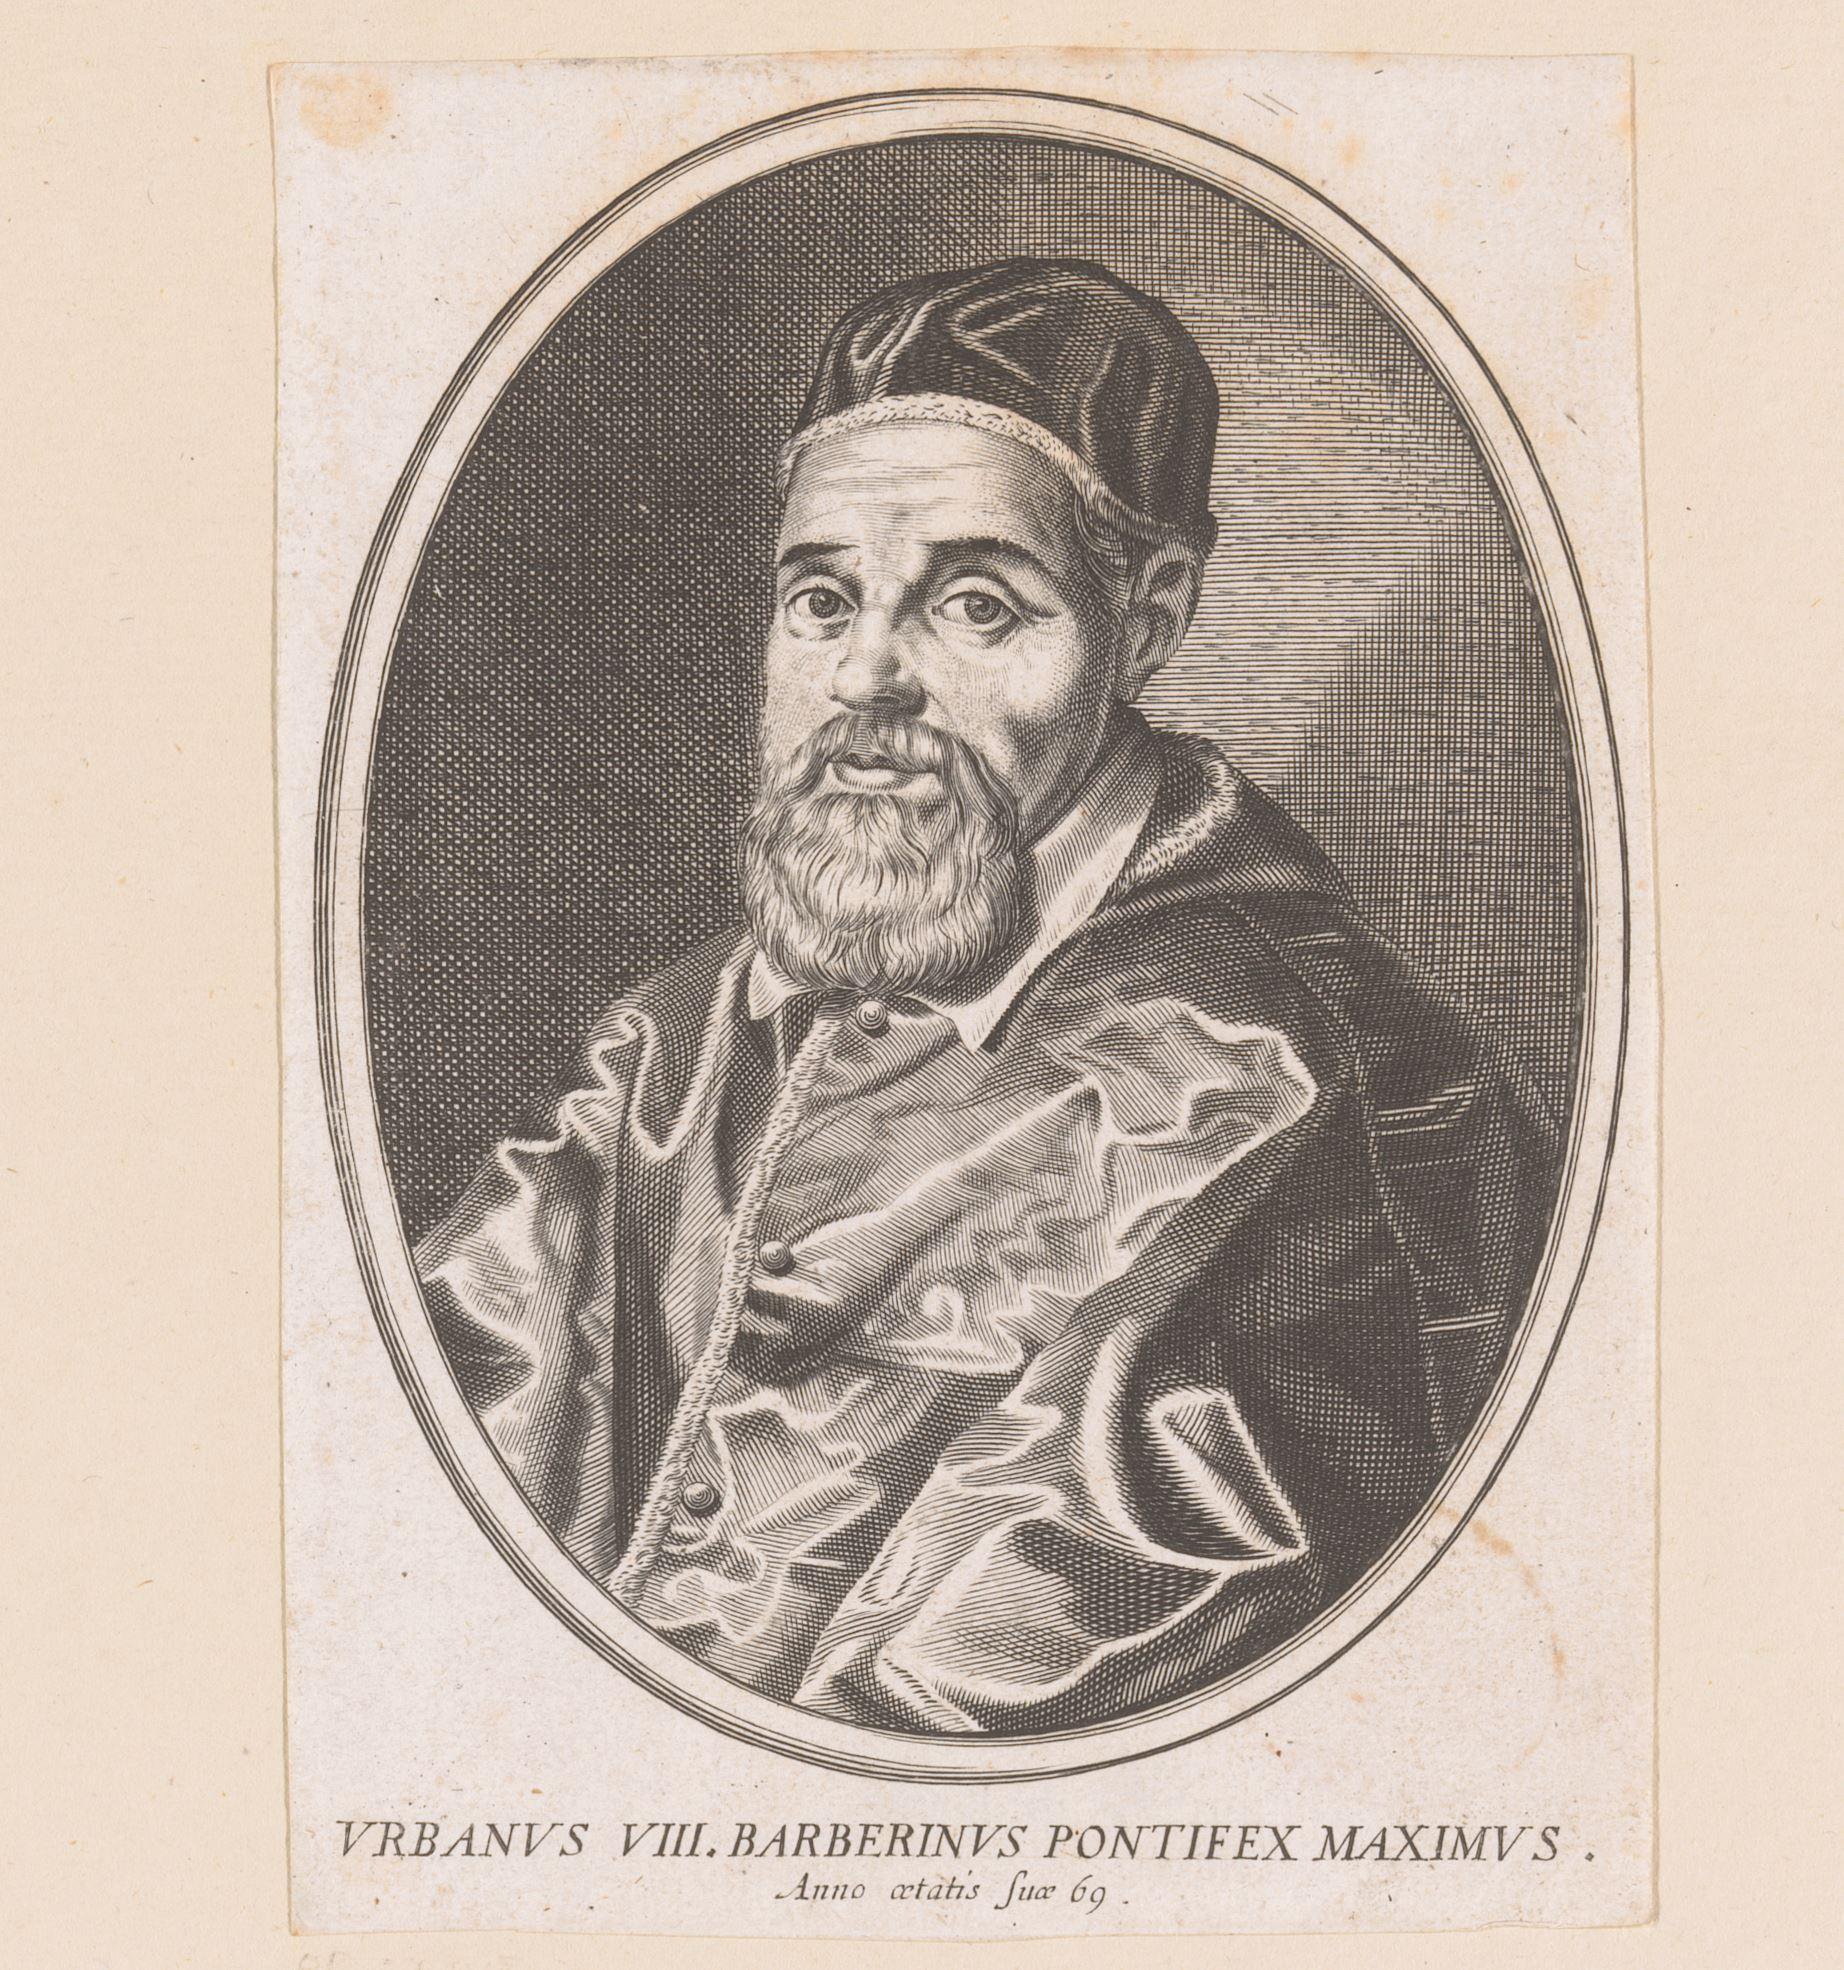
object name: print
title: Portret van paus Urbanus VIII op 69-jarige leeftijd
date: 1610-1668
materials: paper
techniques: engraving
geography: paris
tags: rome, clergyman, urbanus viii, historical persons, pope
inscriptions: collector's mark: Lugt 240